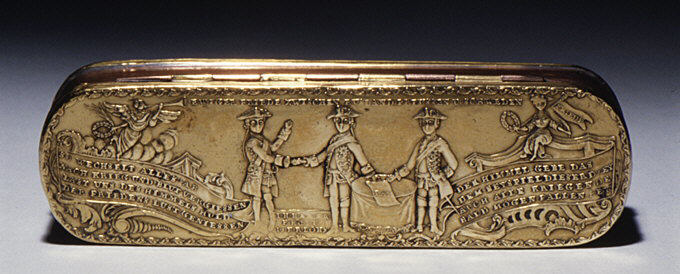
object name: tobacco box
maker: i. h. hamer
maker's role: maker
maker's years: 1700-1800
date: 1765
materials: brass, copper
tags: birds,men,women,lions,coat of arms